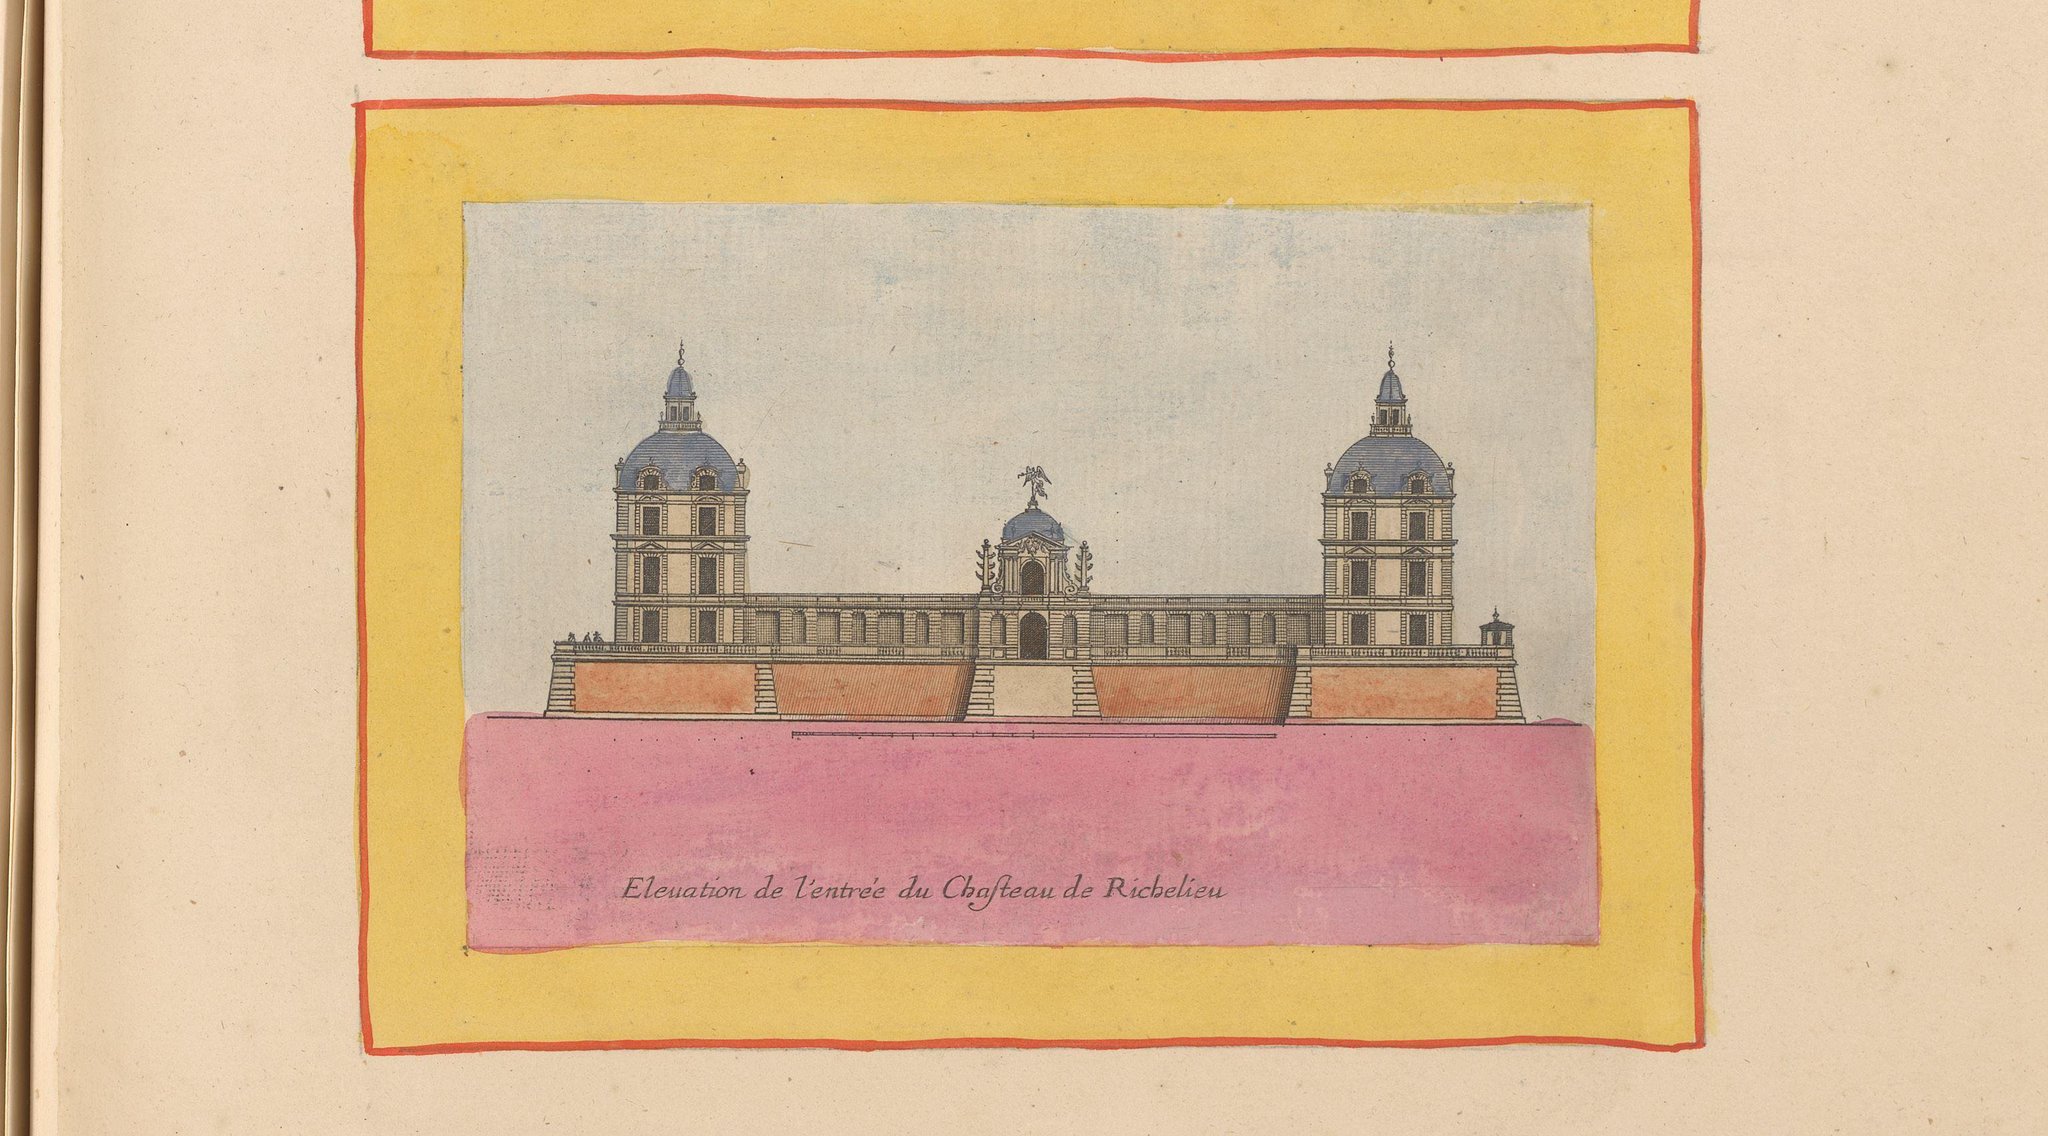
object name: album leaf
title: Kasteel van Richelieu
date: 1629-1679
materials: paper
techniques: etching, hand coloring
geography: the hague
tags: castle, series of designs, models, etc. of one architectural project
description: Deze prent maakt deel uit van een album.